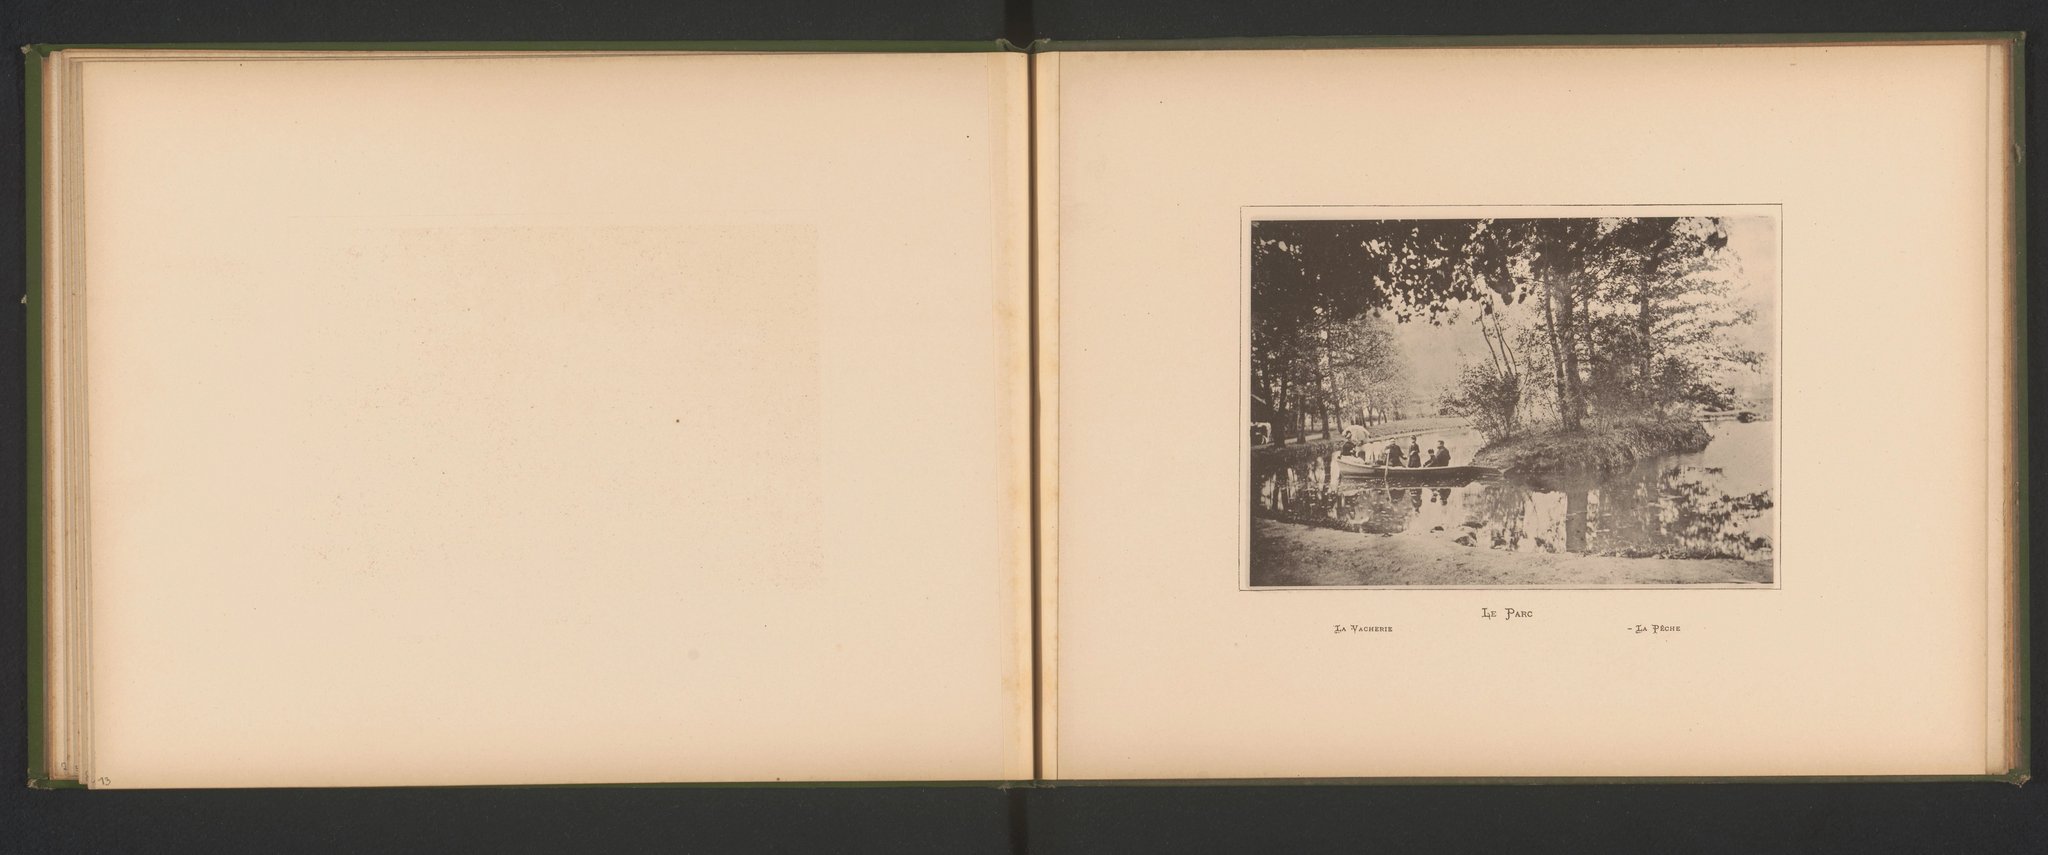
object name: photomechanical print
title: Mensen in een roeiboot in het park in Vittel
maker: Anonymous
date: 1885-1890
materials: paper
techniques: photograph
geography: vittel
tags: park, adult woman, adult man, rowing-boat, canoe, etc.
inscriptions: inscription: ‘La Vacherie - La Pêche’